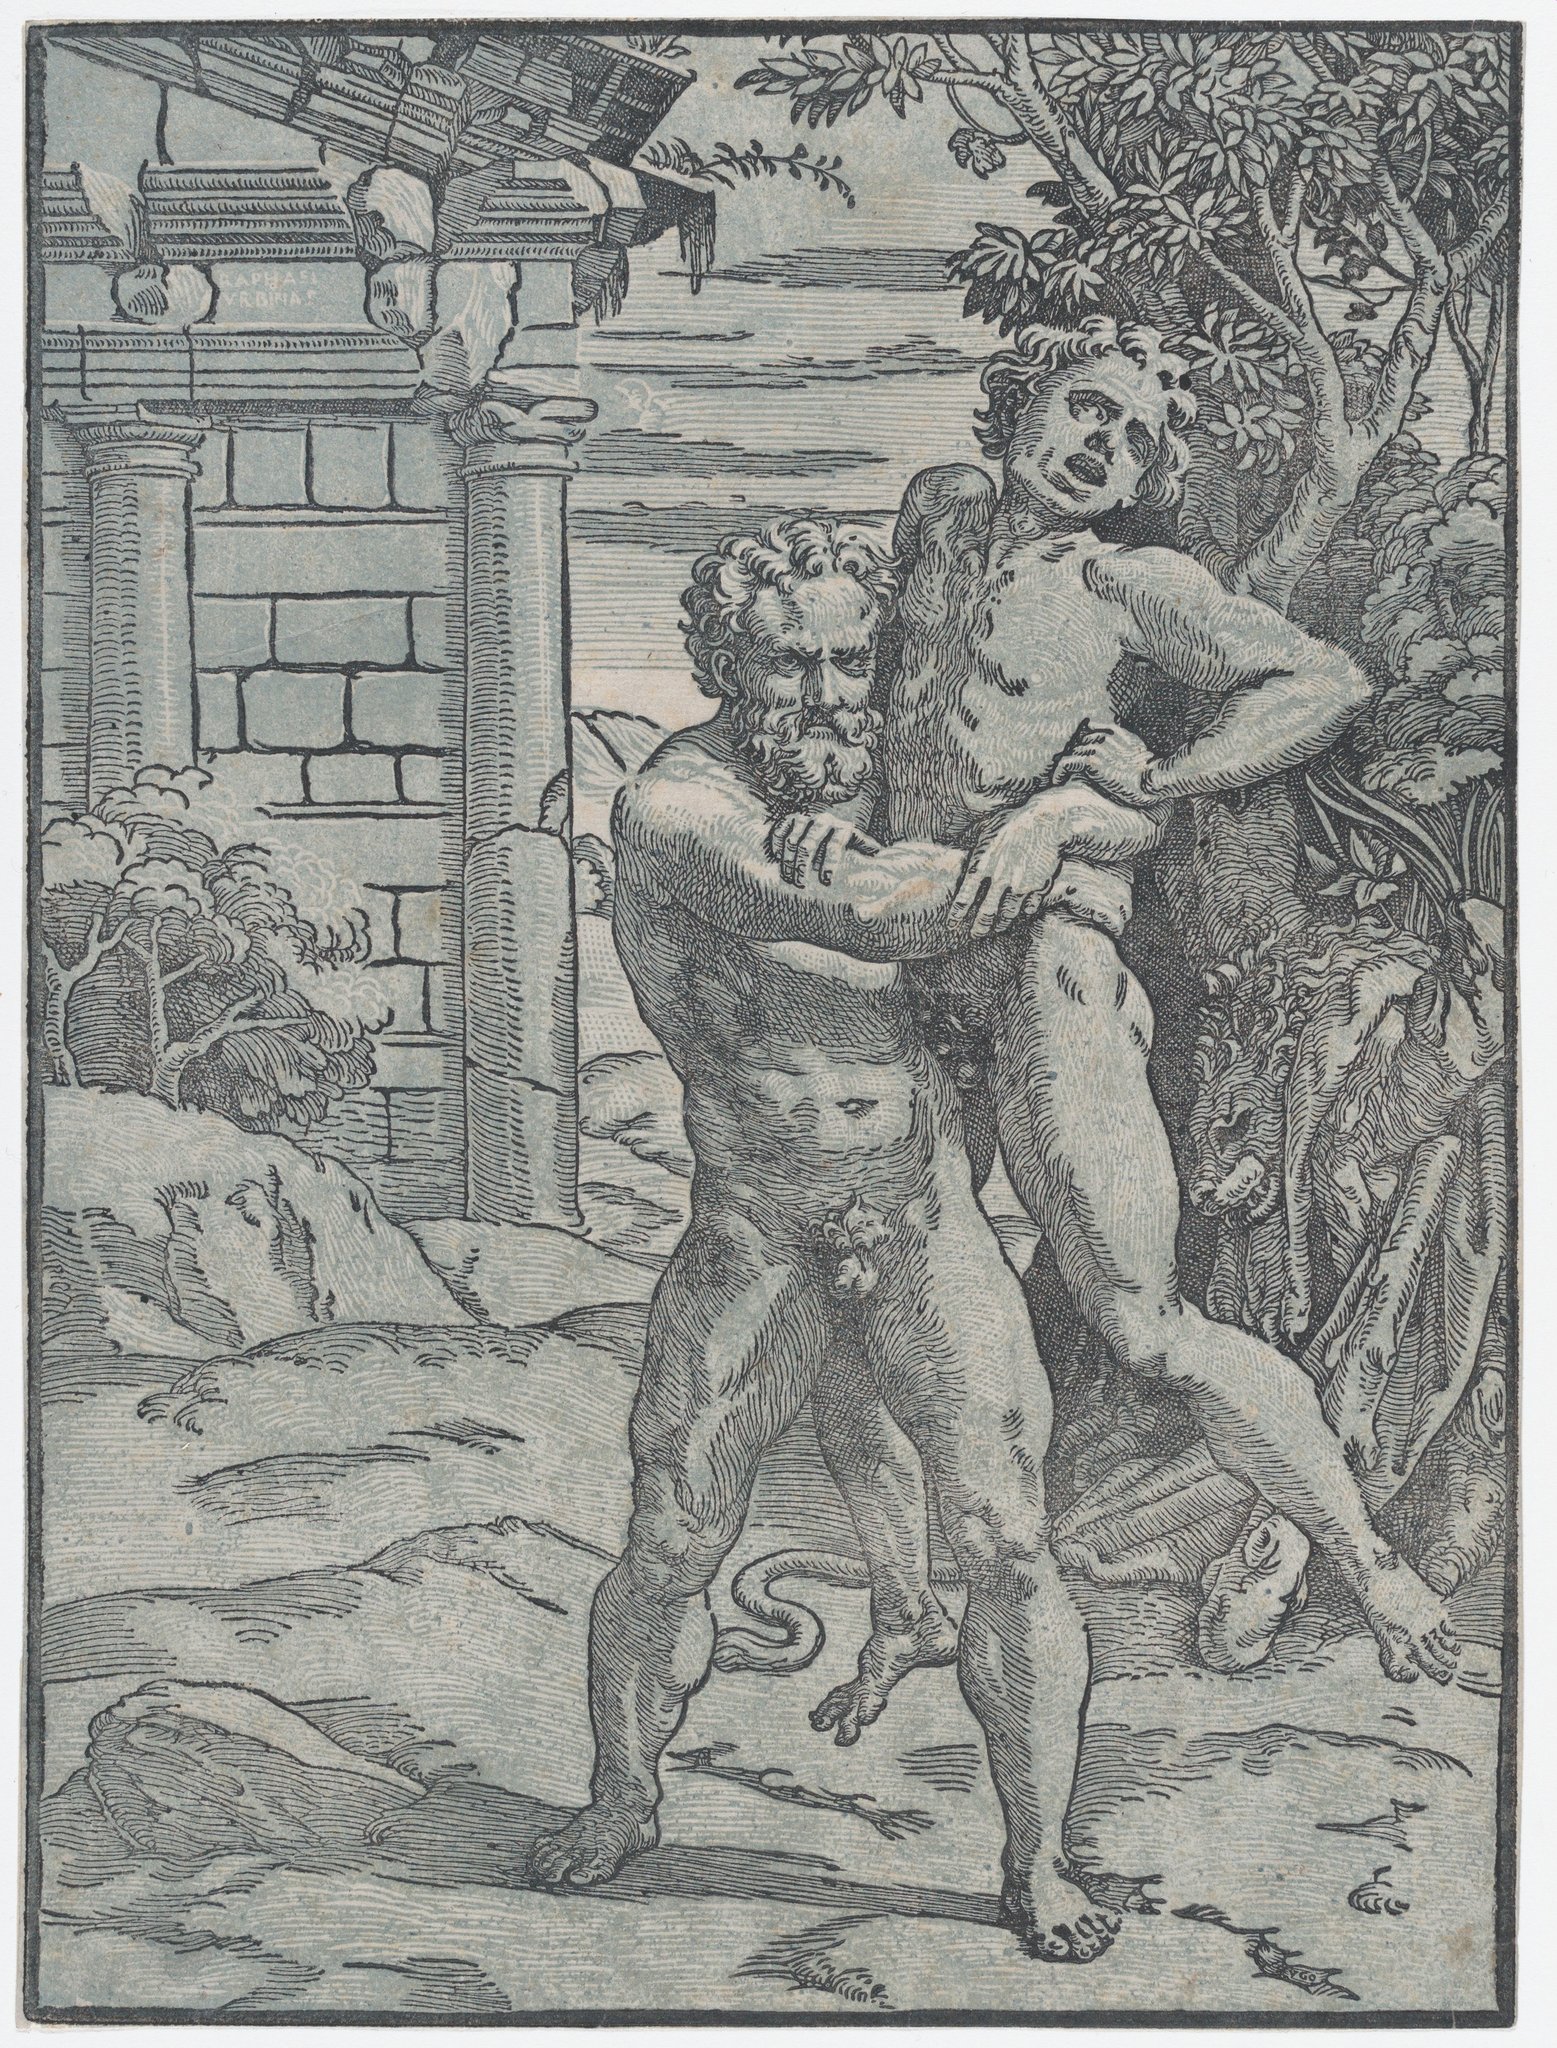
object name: print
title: Hercules and Antaeus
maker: ugo da carpi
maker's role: artist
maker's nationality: italian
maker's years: 1480-1532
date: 1517-1518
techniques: woodcut, printing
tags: men,male nudes,hercules